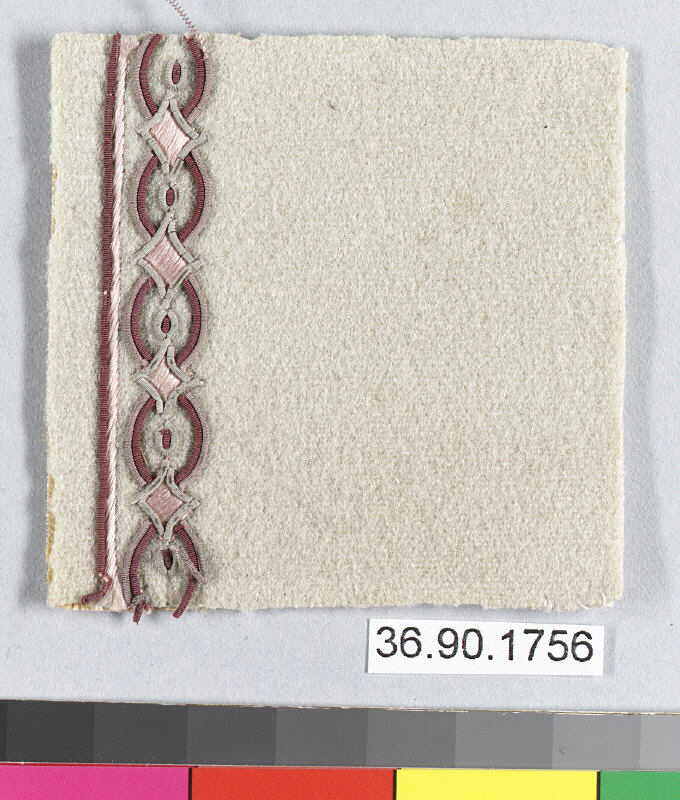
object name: sample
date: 1801-1833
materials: felt, metal thread, silk